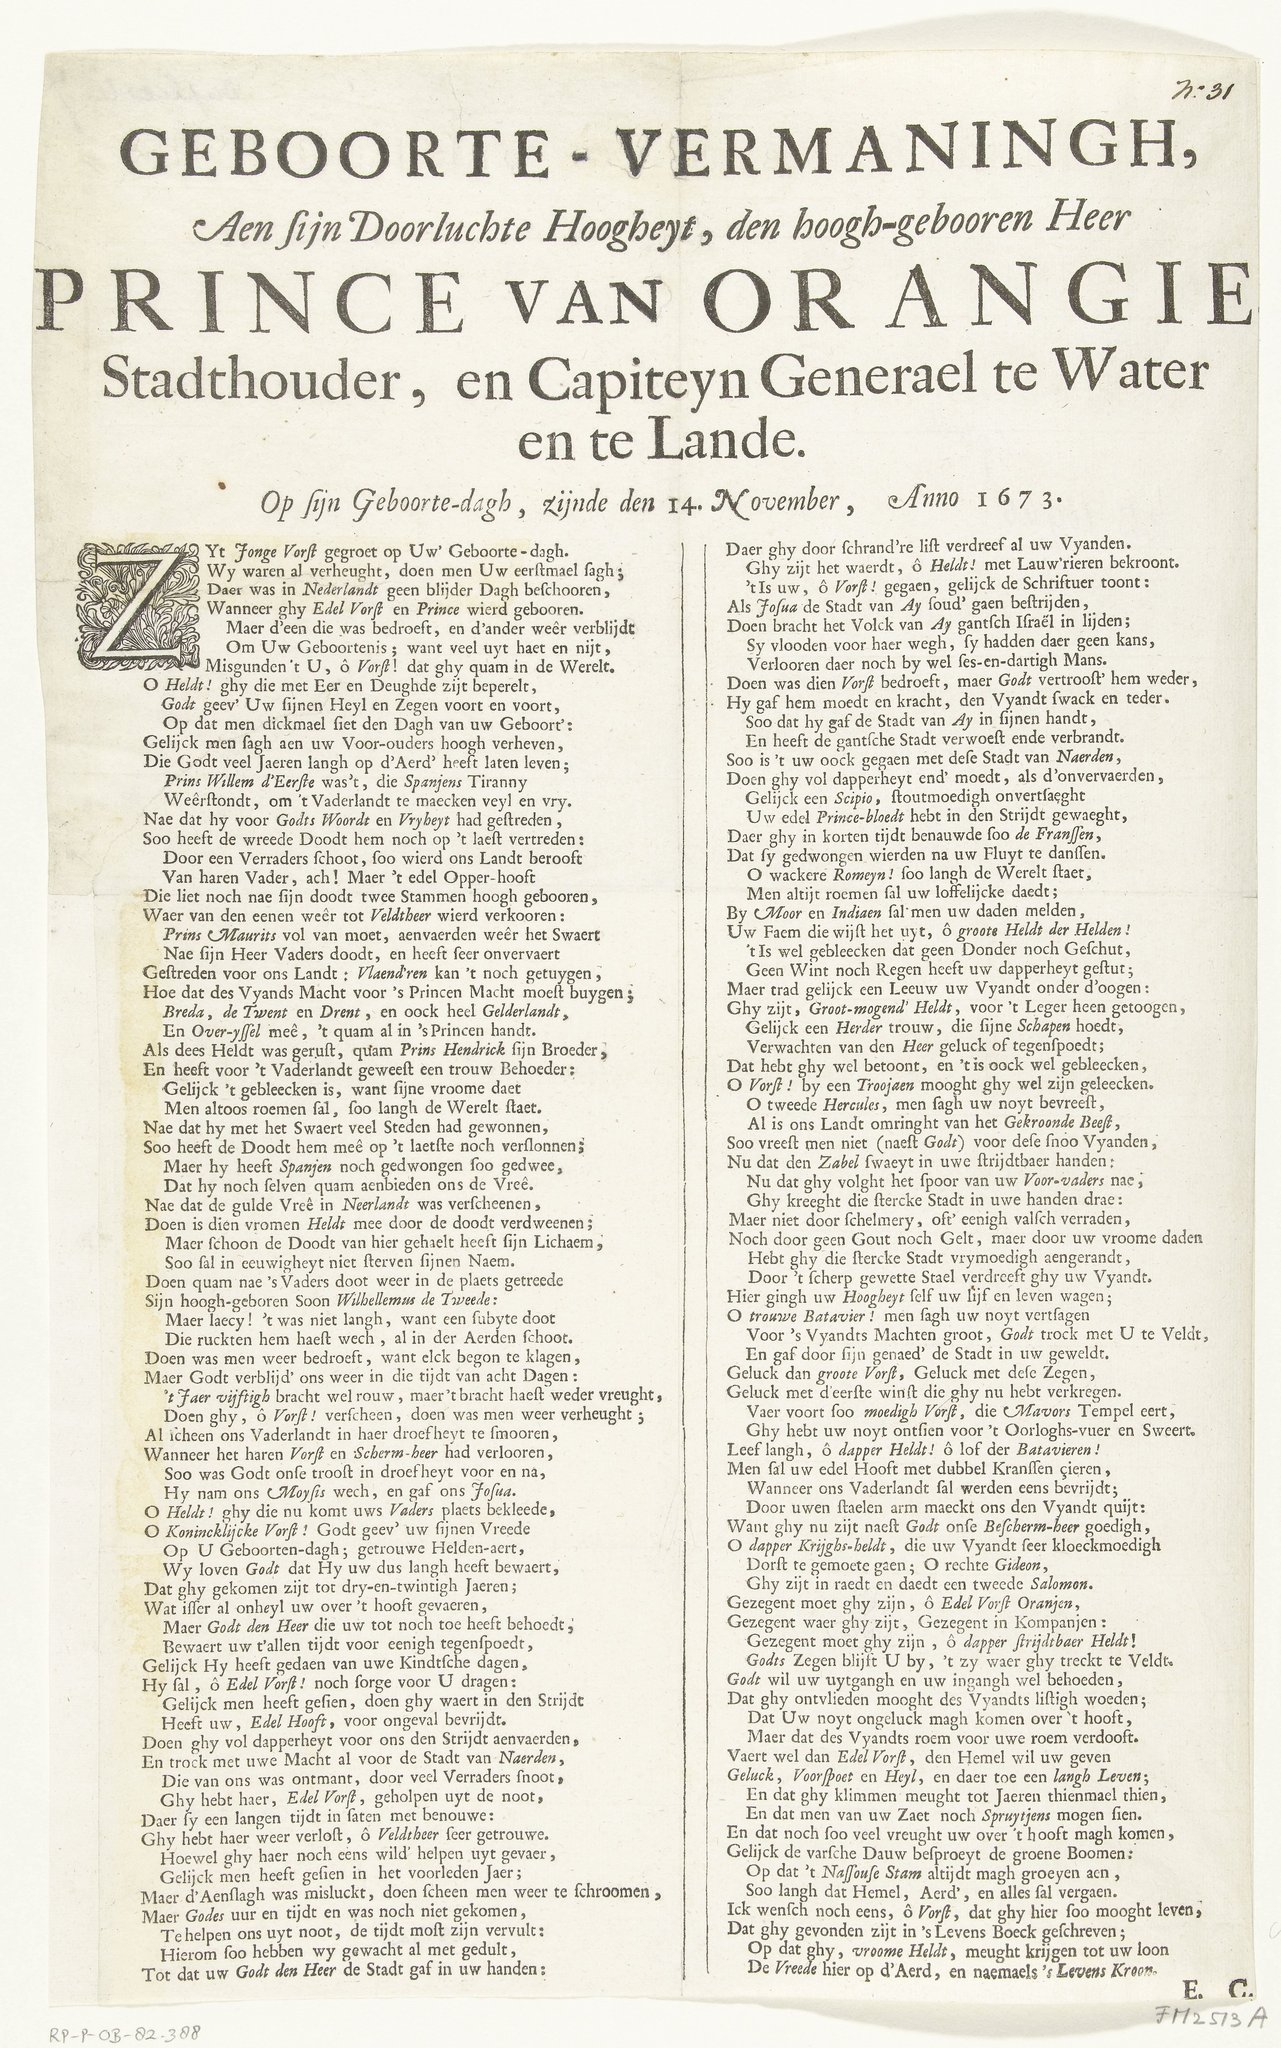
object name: text sheet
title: Lofdicht op prins Willem III, 1673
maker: Anonymous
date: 1673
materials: paper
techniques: letterpress printing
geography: northern netherlands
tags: william iii (prince of orange and king of england, scotland, and ireland)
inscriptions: collector's mark: Lugt 2760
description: Lofdicht op prins Willem III op zijn 23ste verjaardag op 14 november 1673. Vers in twee kolommen, ondertekend met: E.C.